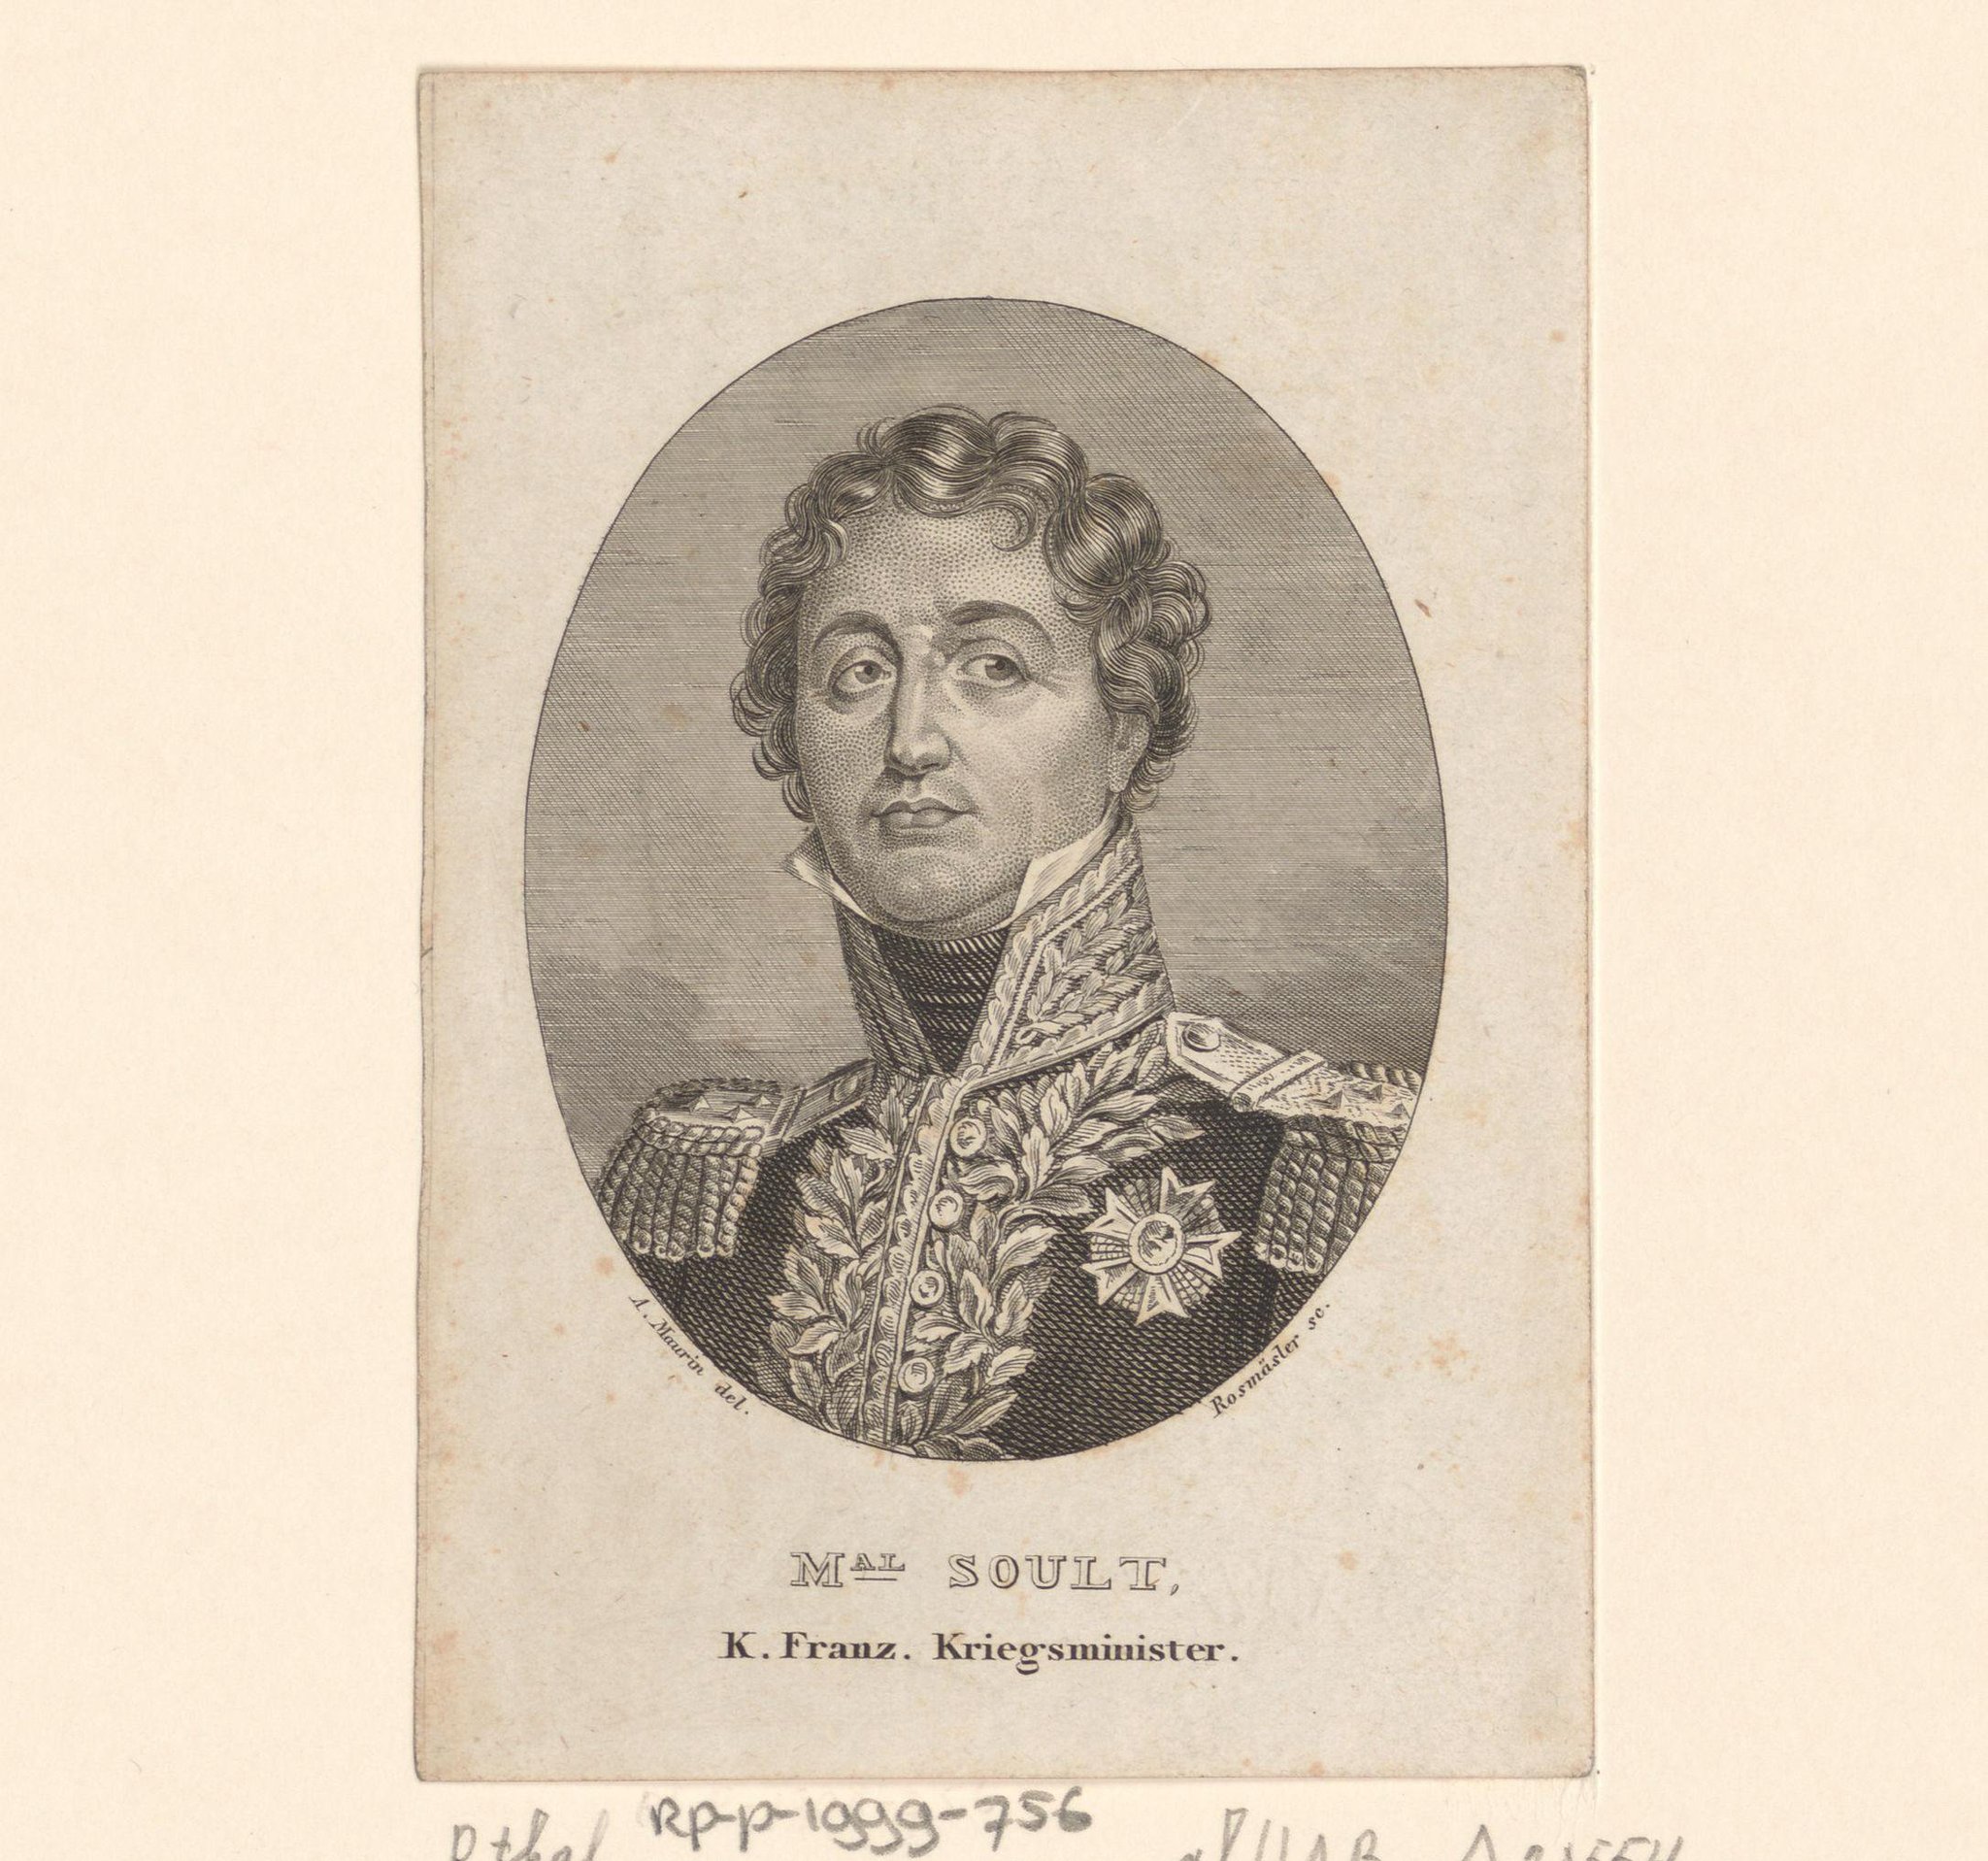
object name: print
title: Portret van Nicolas Jean-de-Dieu Soult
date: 1804-1858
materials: paper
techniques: engraving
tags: commander-in-chief, general, marshal, historical persons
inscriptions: collector's mark: Lugt 2228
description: Met eenregelig onderschrift in het Duits.